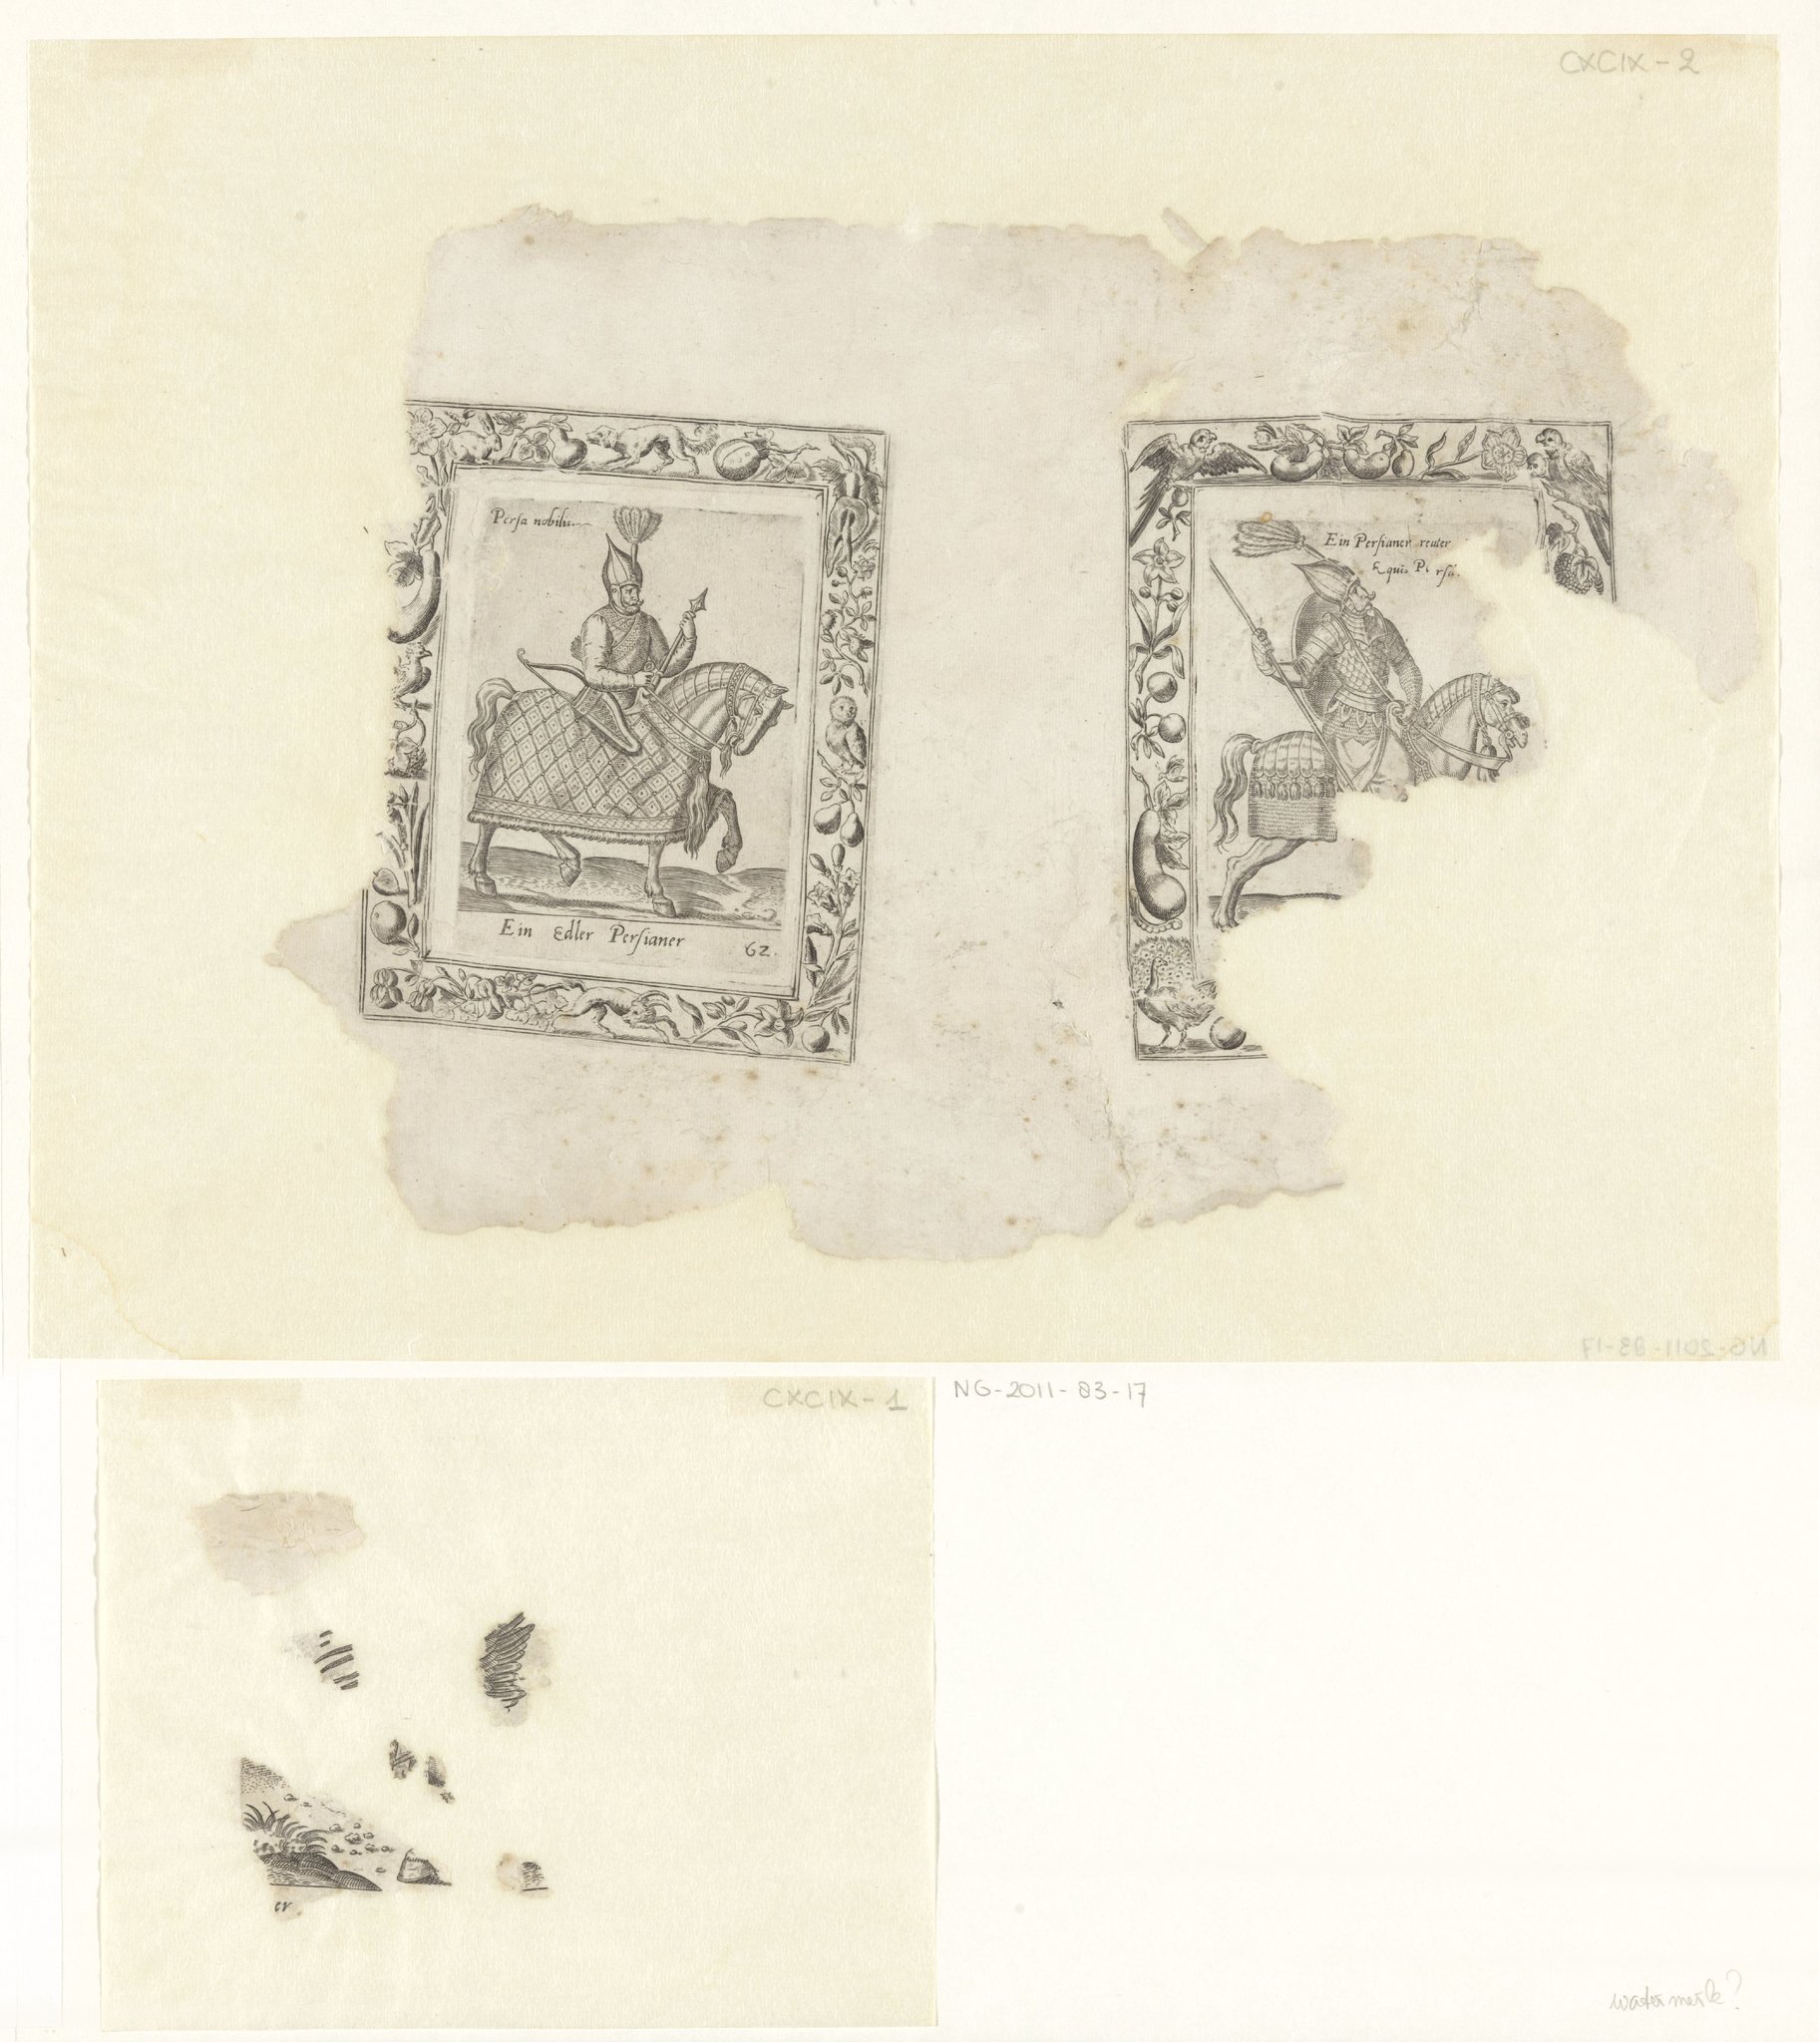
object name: costume print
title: Perzische edelman en ruiter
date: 1576-1596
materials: paper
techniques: engraving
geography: cologne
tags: warfare; military affairs (+ cavalry, horsemen), folk costume, regional costume, military clothing and other equipment (uniforms, cap, armour, helmet, etc.)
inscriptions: watermark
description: Prent 62 en 63 uit een serie van 77, mogelijke serietitel Diversarum gentium armatura Equestris. Latere editie van serie Equitum Descripcio, Quomodo Equestres (...). De prenten in de Nova Zembla collectie zijn tijdens een expeditie van Willem Barendsz en Jacob van Heemskerk in 1596-1597 noodgedwongen in het winterkamp, het ‘Behouden Huis’, op het eiland achtergelaten. De prenten waren in één of meerdere stapels als handelswaar meegenomen vanuit Amsterdam. Bijna drie eeuwen later, in 1871, keerde de Noor Elling Carlsen terug naar Nova Zembla en vond daar de restanten van het ‘Behouden Huis, inclusief een groot deel van de inventaris. Een deel van de prenten, in de vorm van aaneengekoekte kluiten, werd toen ook teruggevonden. De papierkluiten waren soms op meerdere plekken gebroken. Tussen 1975-1979 zijn de prenten van elkaar gescheiden. Dit leverde in totaal ca. 1000 fragmenten van ca. 400 afdrukken van ca. 150 verschillende prenten op. Voor zover mogelijk zijn de fragmenten samengevoegd en zijn de prenten gereconstrueerd.